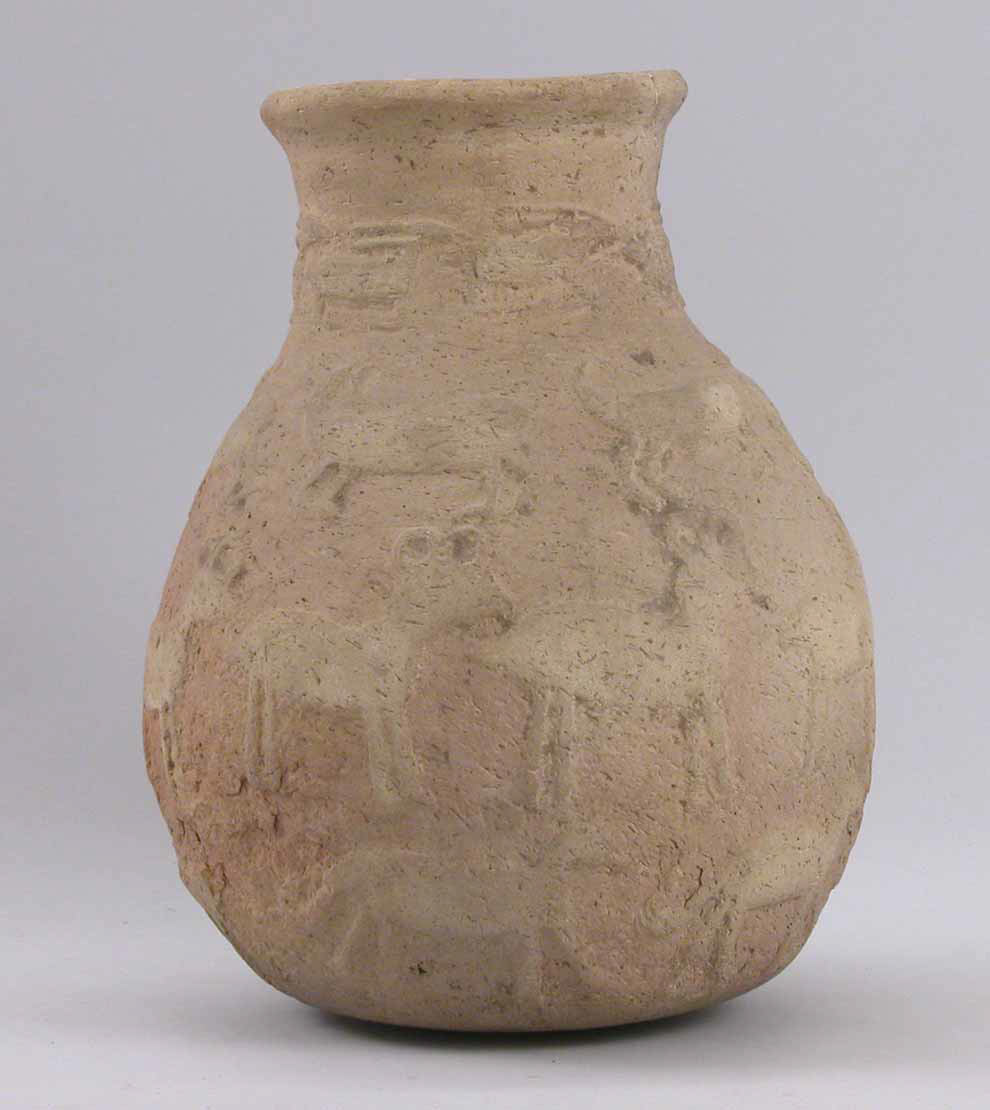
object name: jar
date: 601-800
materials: earthenware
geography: iraq